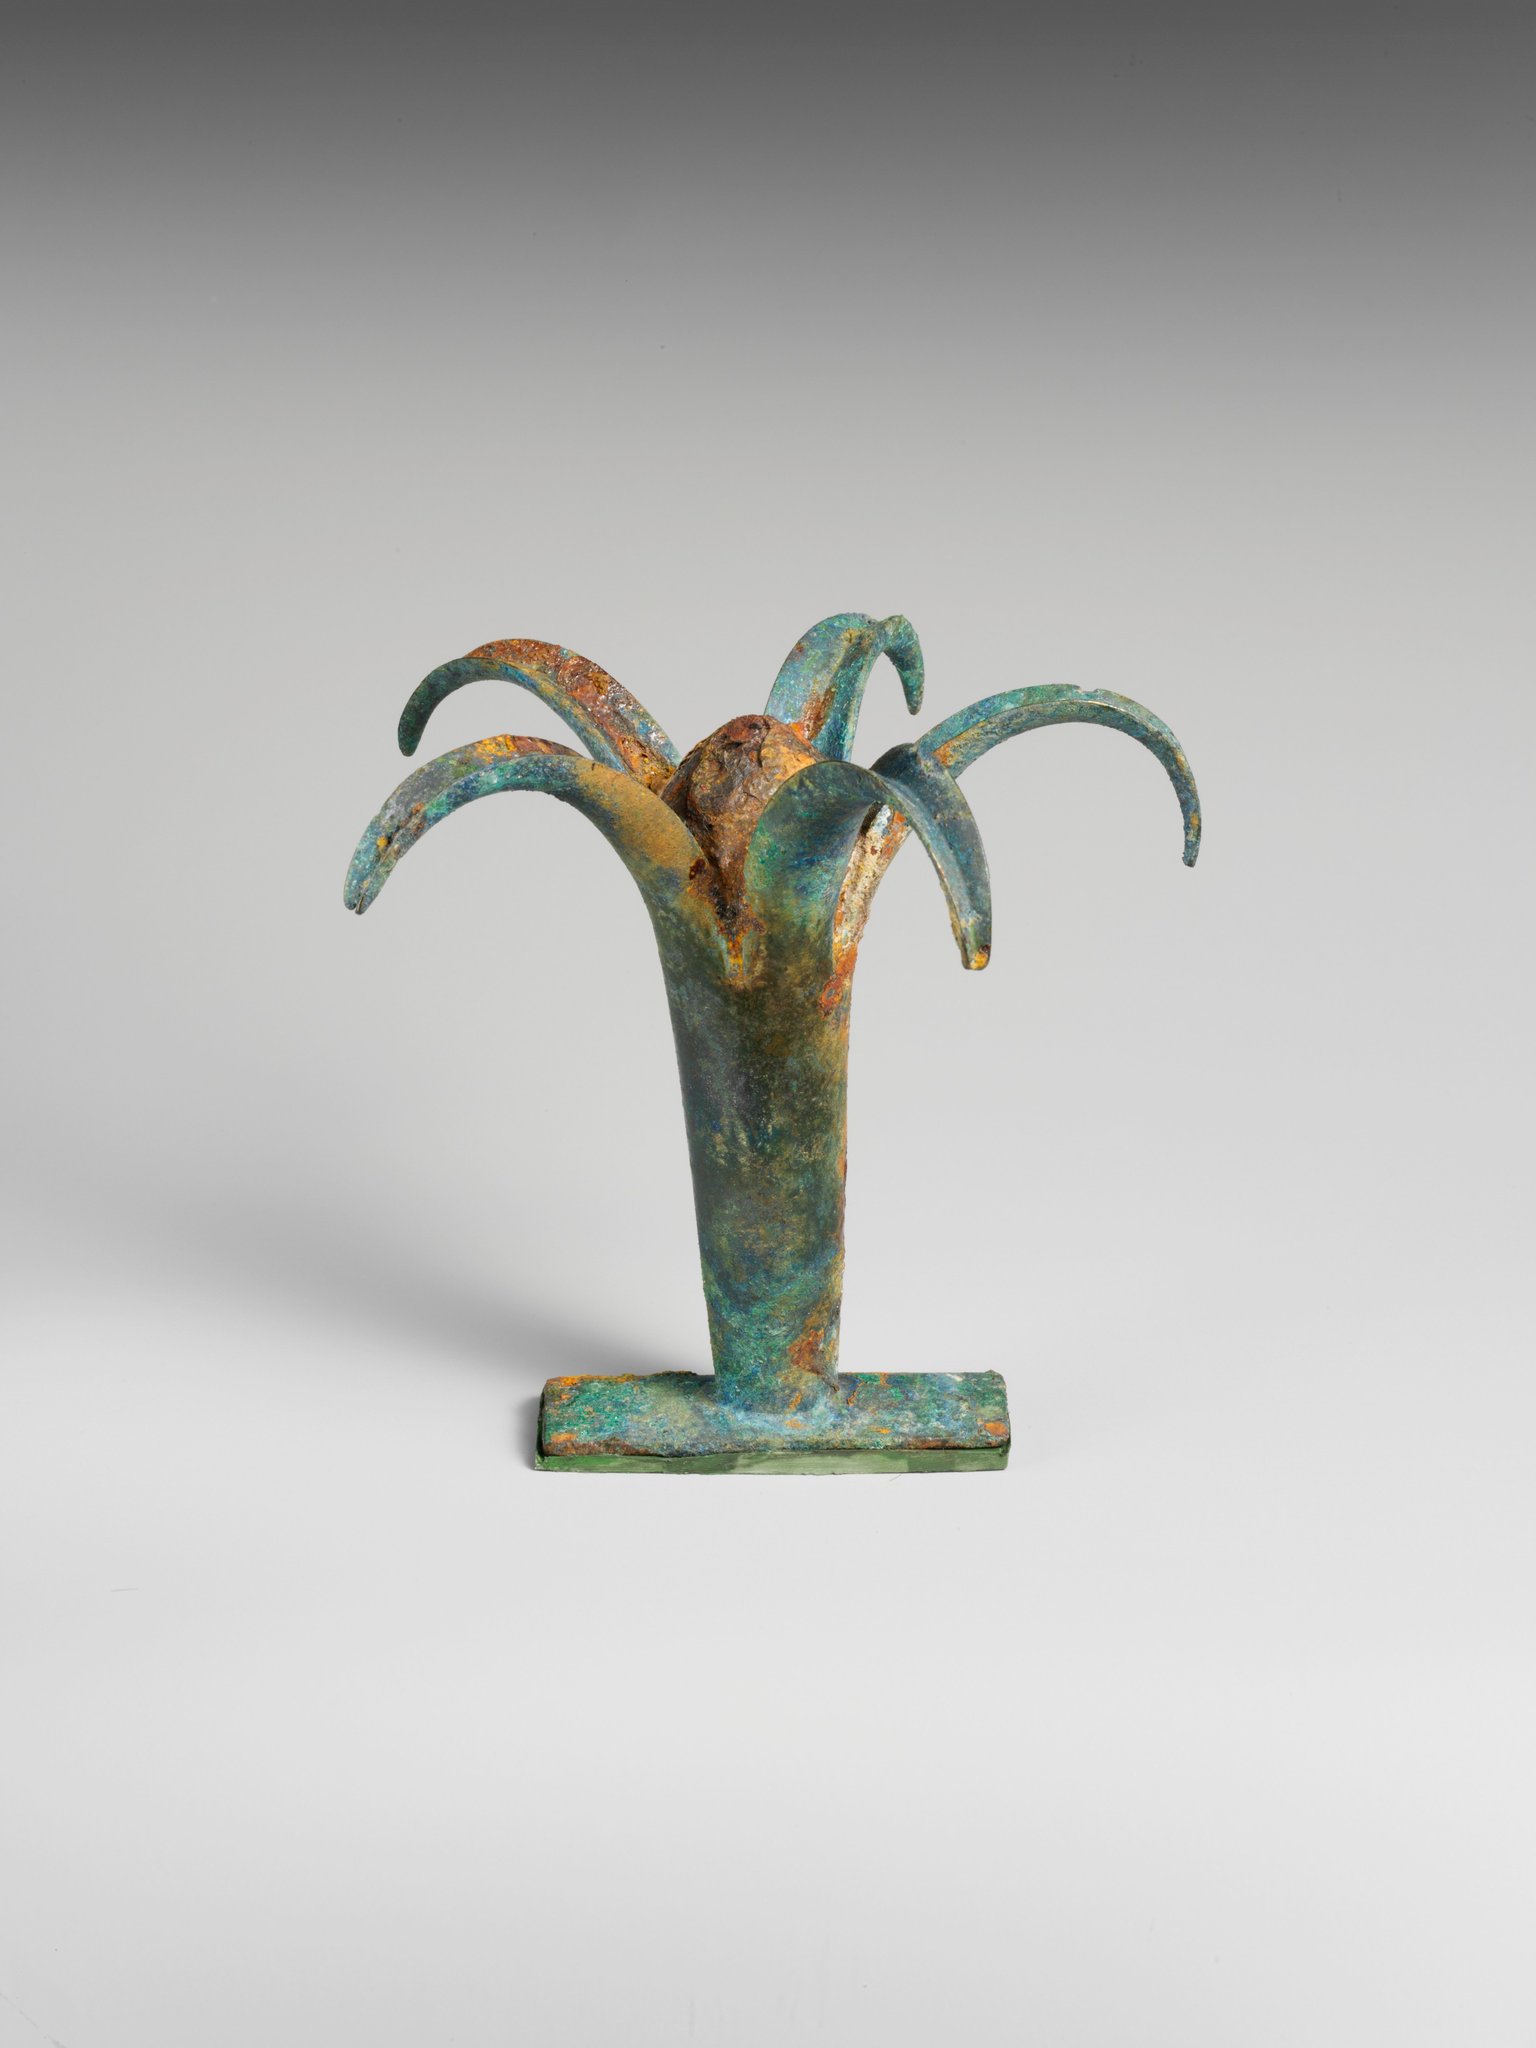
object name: fragment, floral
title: Bronze floral element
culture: etruscan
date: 550-500 BCE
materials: bronze